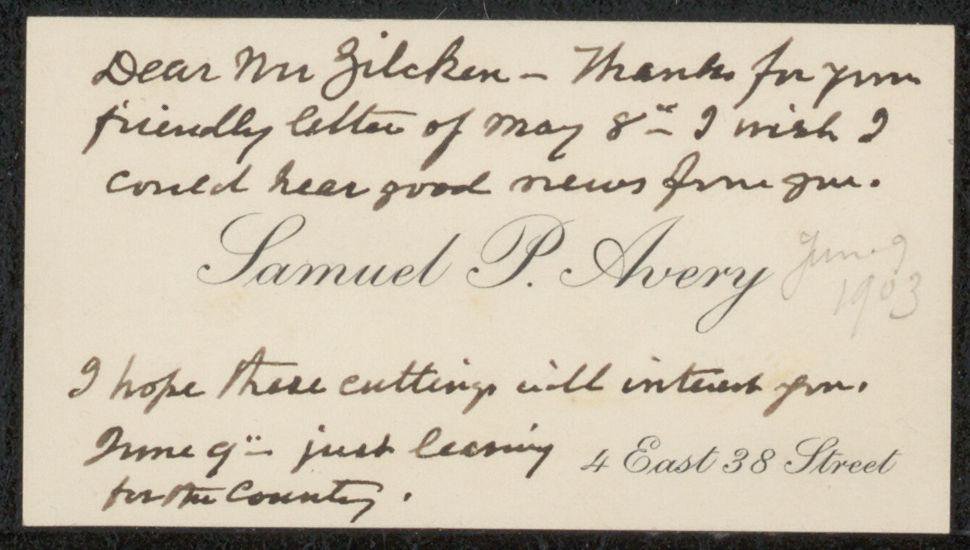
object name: visiting card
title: Visitekaartje aan Philip Zilcken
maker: samuel putnam avery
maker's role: verzamelaar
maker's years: 1822-1904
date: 1832-1904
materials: ink, paper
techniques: pen, printing, writing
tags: the hague, painter, philip zilcken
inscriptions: collector's mark: ‘RPK’